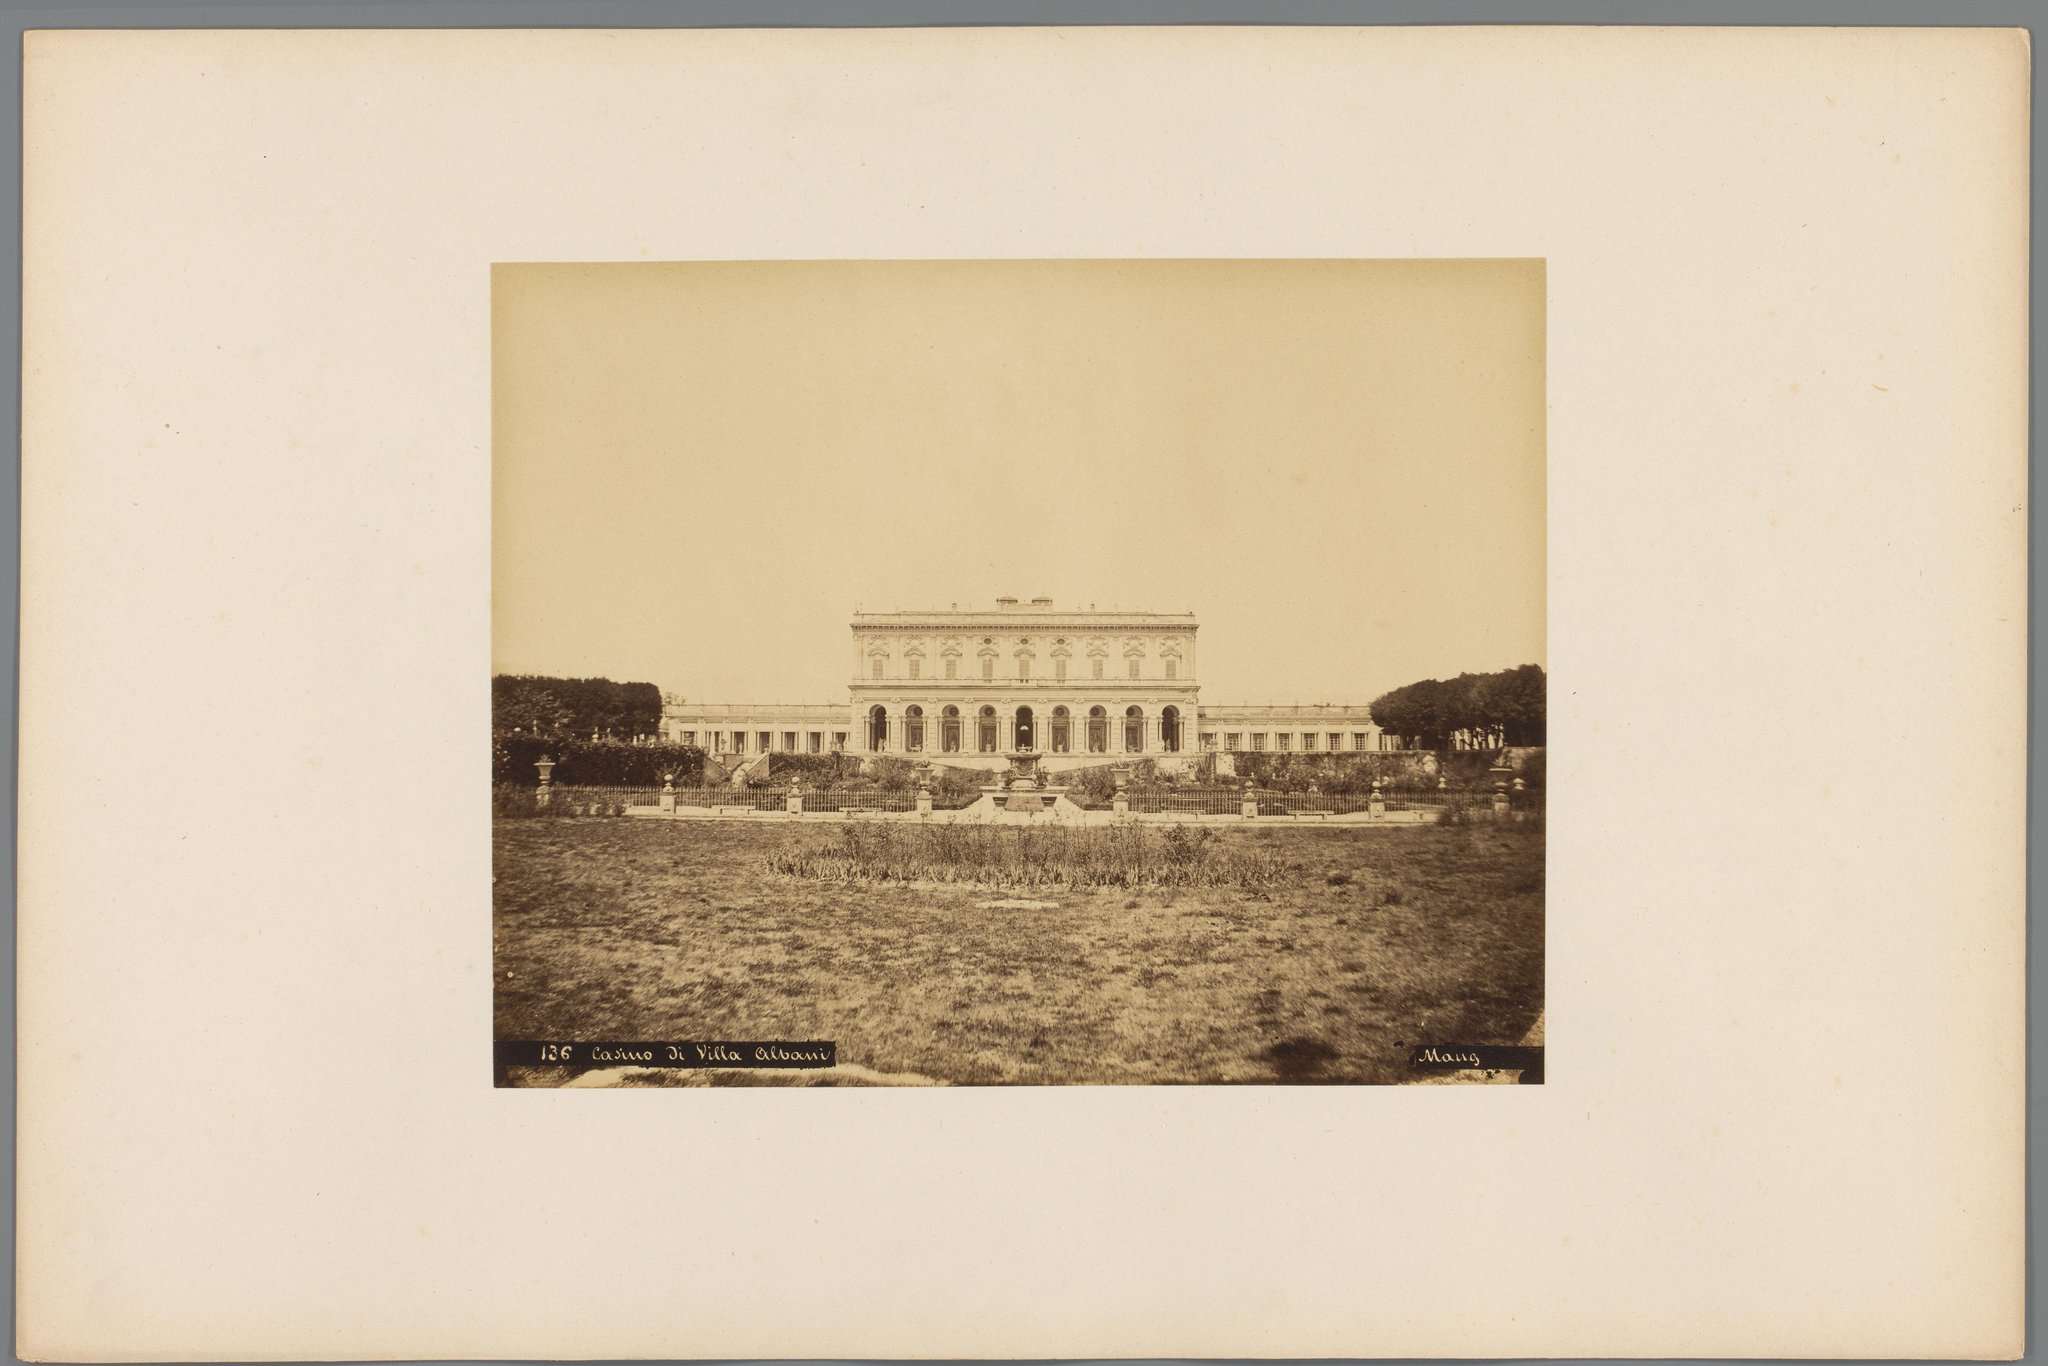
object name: photograph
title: Casino di Villa Albani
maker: michèle mang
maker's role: fotograaf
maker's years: 1840-1909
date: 1863-1887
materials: cardboard, paper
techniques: albumen print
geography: rome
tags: exterior ~ representation of a building, civic architecture; edifices; dwellings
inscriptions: number: ‘136’